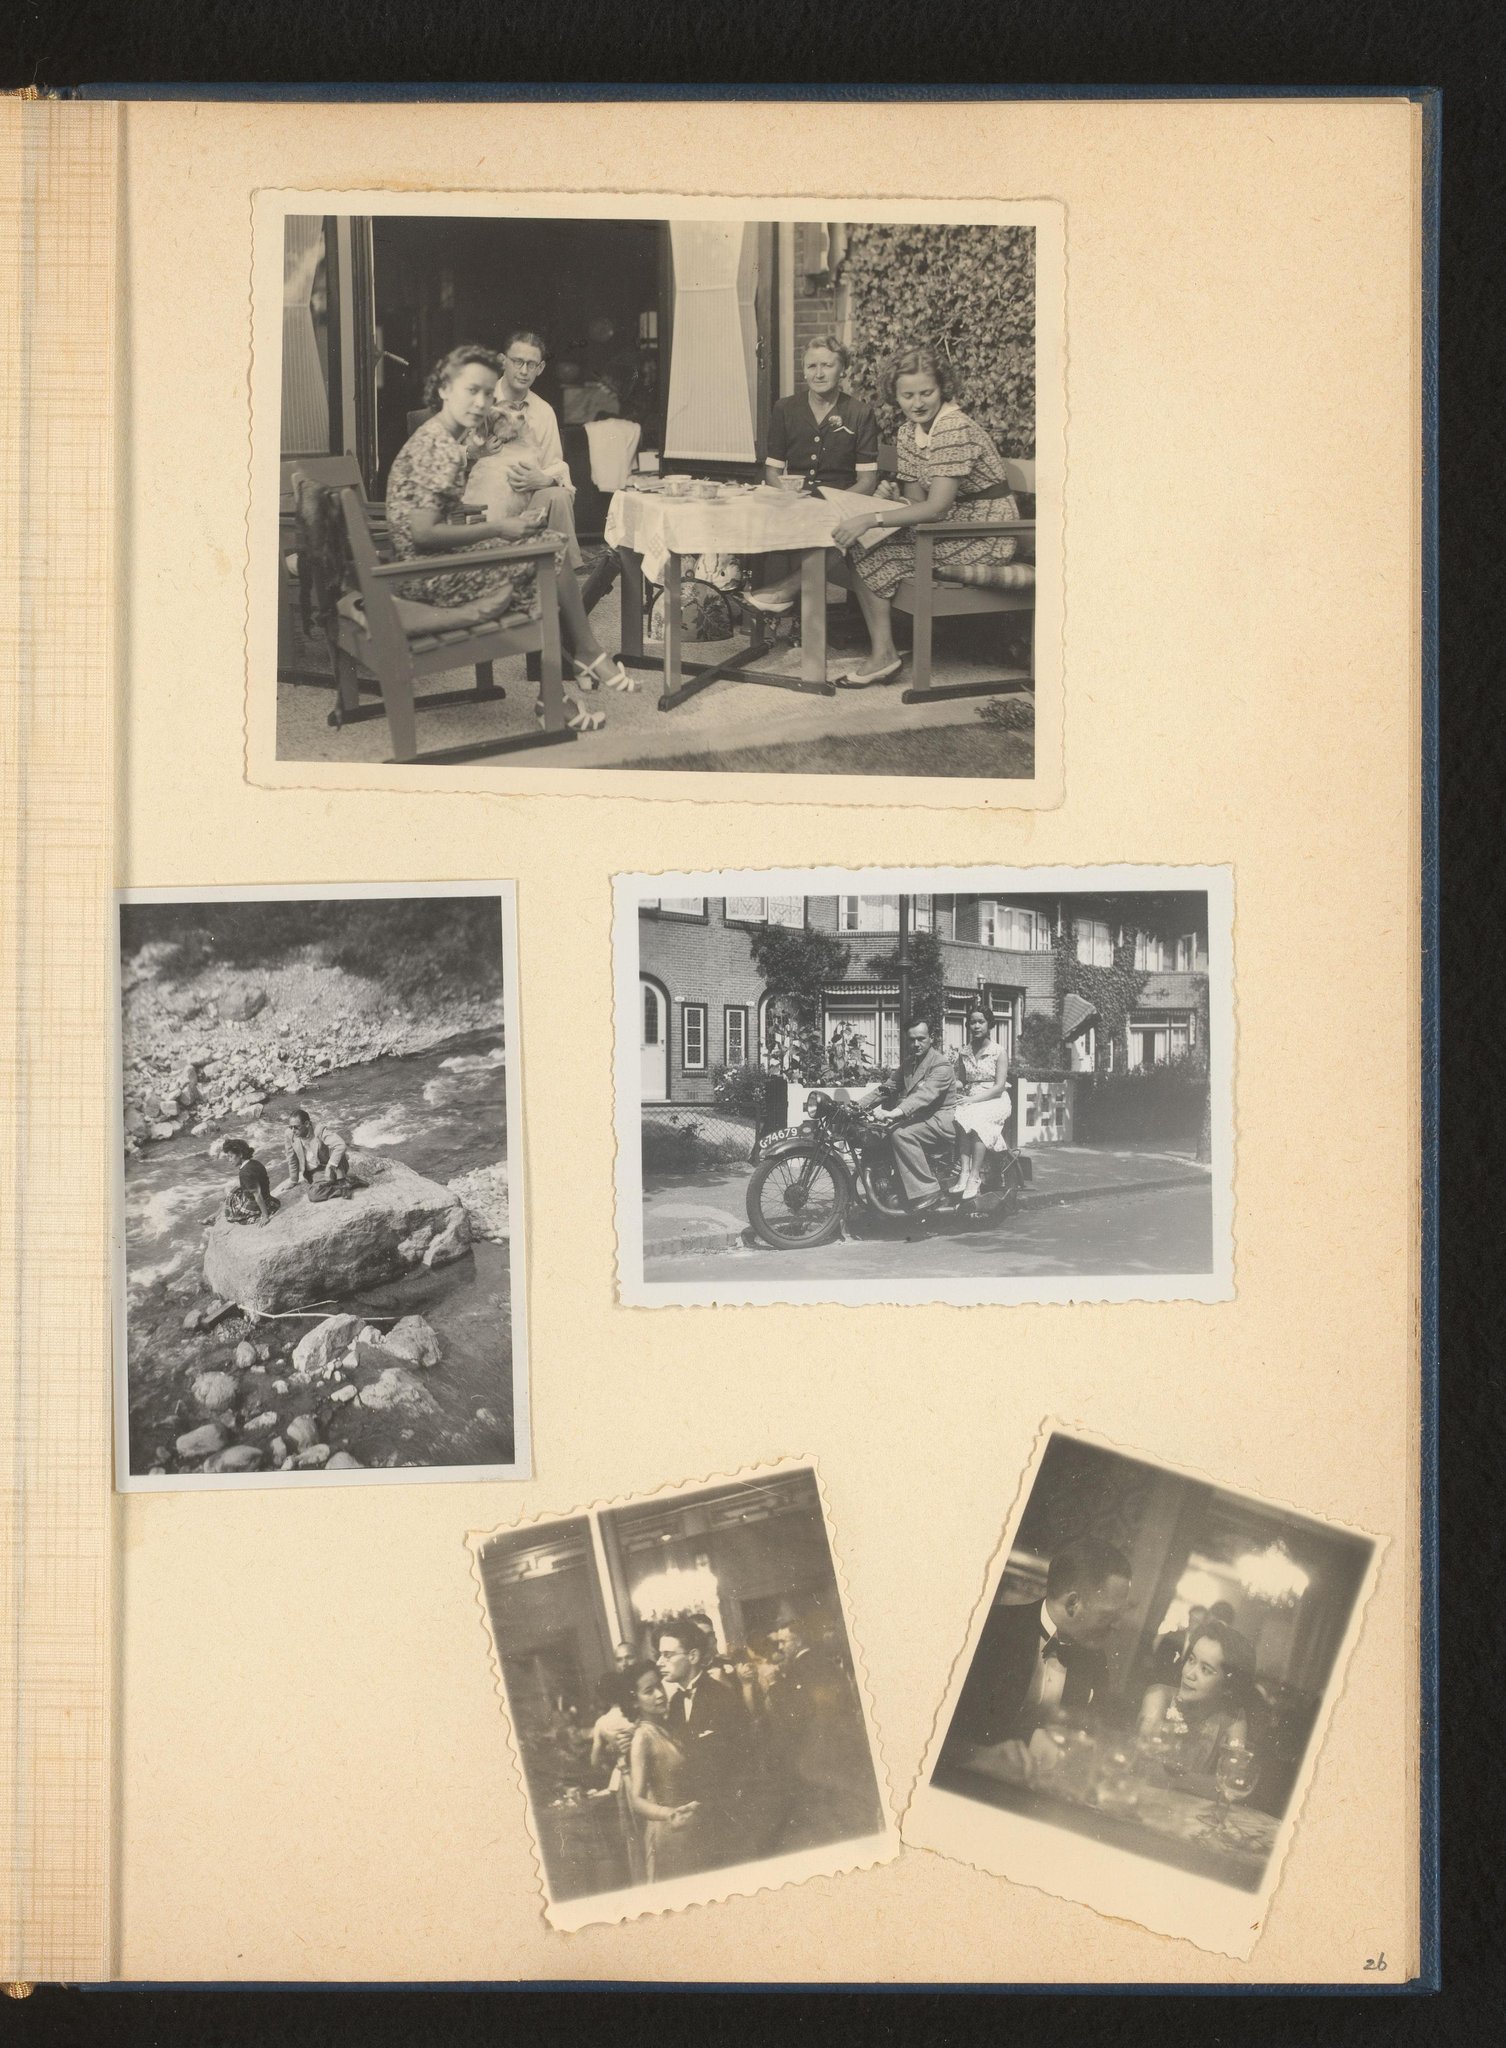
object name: album leaf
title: Eef Dumas en Max Nord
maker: Anonymous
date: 1935-1940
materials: cardboard, photographic support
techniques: gelatin silver print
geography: netherlands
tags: surabaya, paris, beatrice jacqueline eveline dumas, amsterdam, max nord, historical persons - bb - woman, motor-cycles and other two-wheeled motor-vehicles, historical persons, netherlands, dutch east indies, the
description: Blad met vijf foto's van Eef Dumas en Max Nord, poserend op de motor, op vakantie, met een hond op schoot in de tuin en samen op een bal. Onderdeel van het fotoalbum van Beatrice Jacqueline Eveline (Eef) Dumas, ca. 1880-1952.